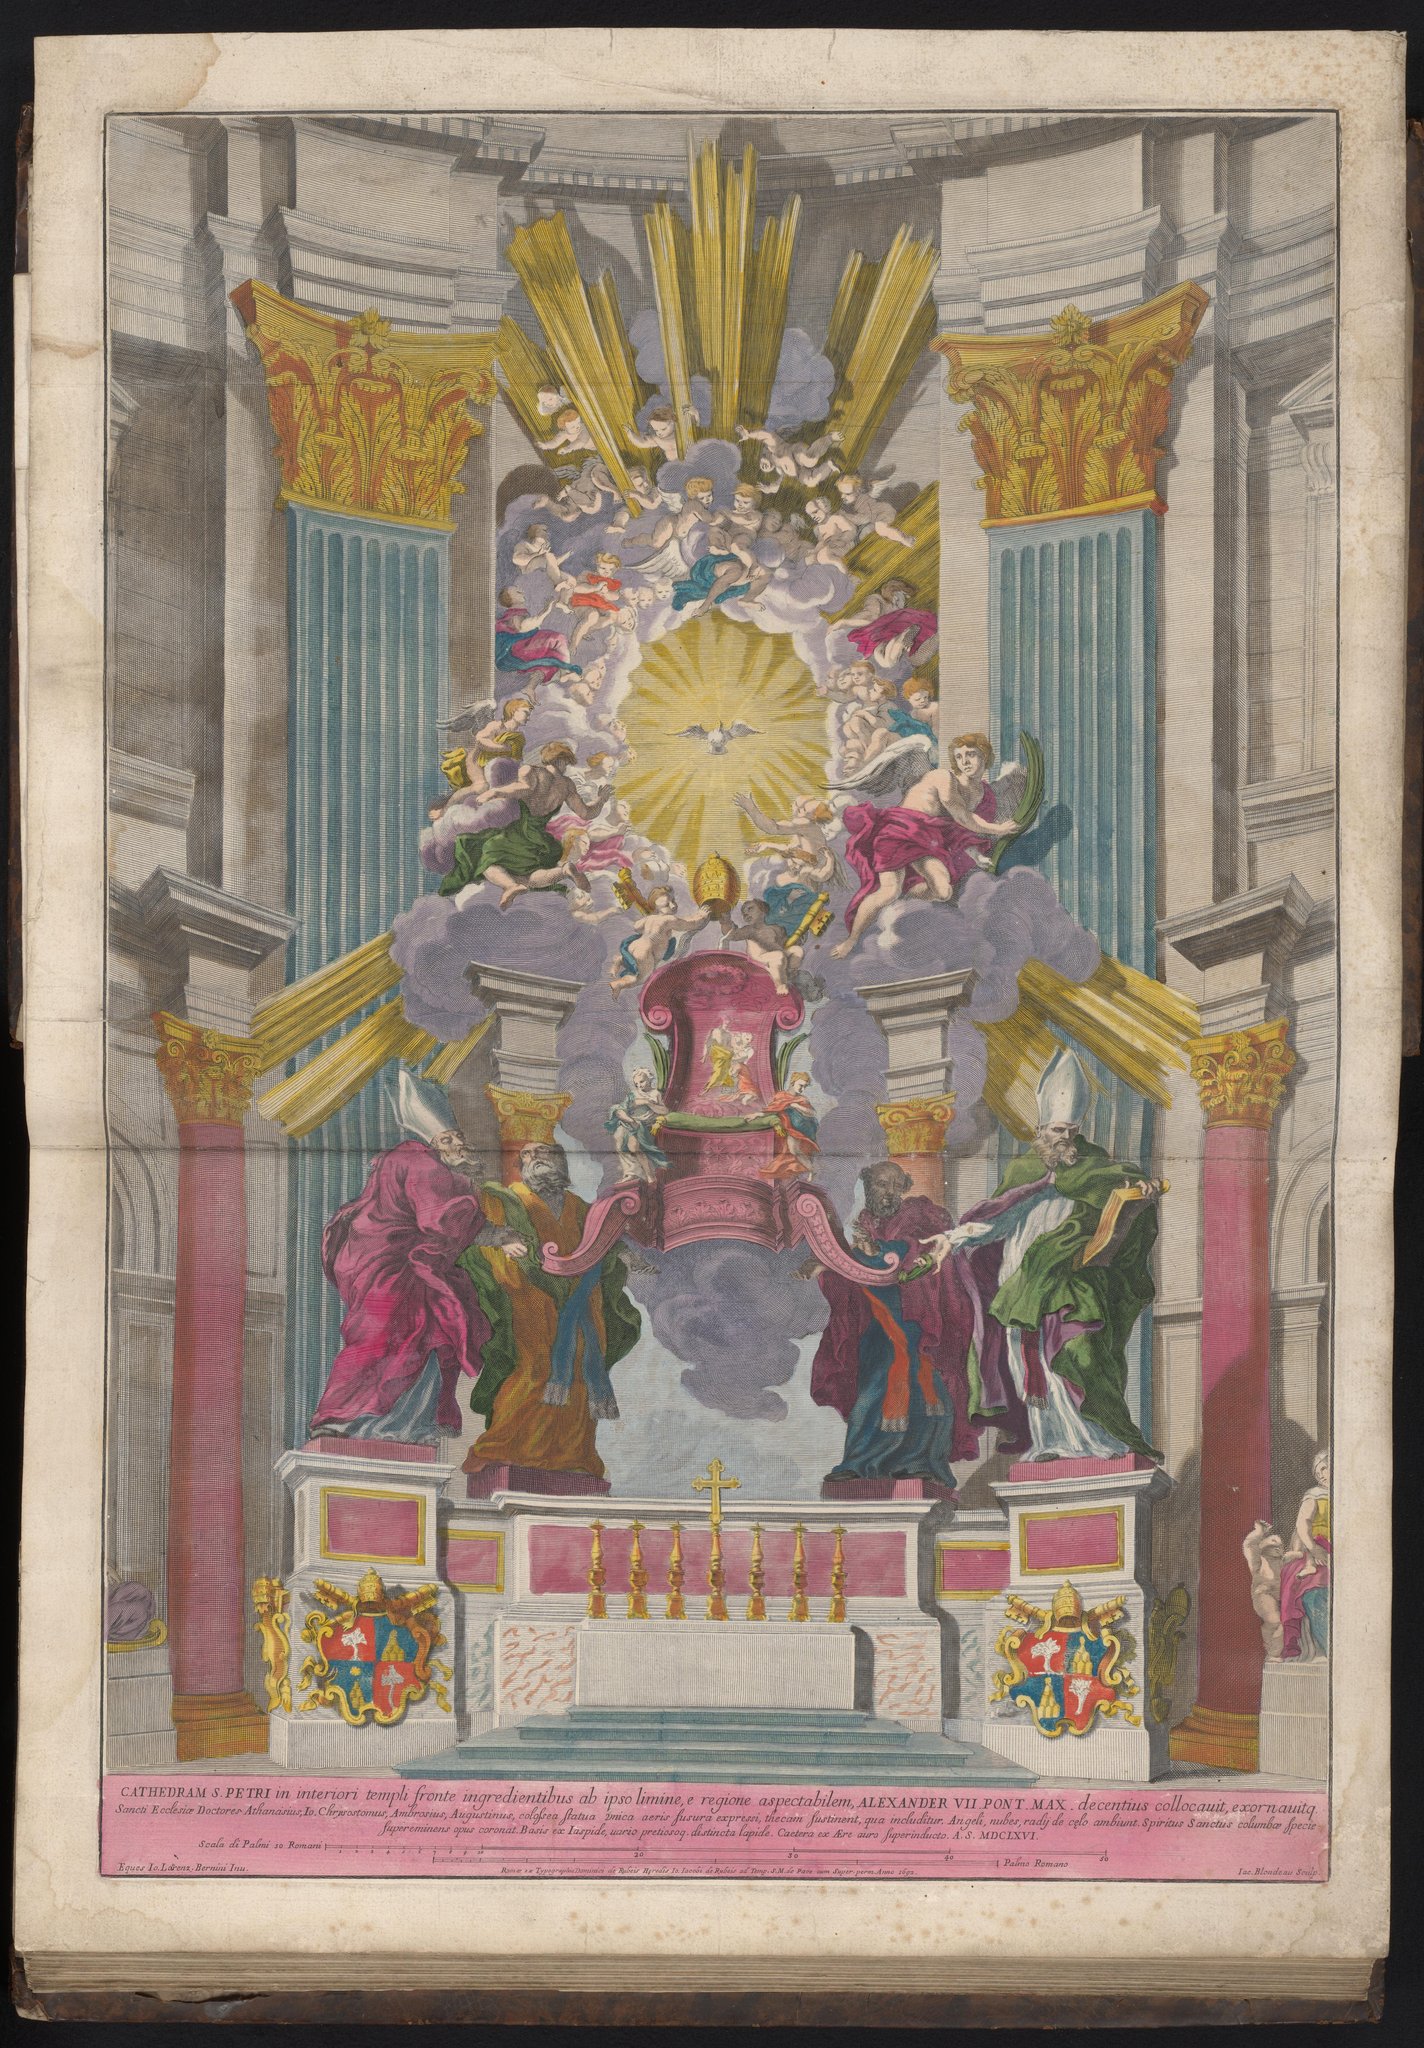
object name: album leaf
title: Cathedra Petri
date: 1692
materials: paper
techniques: colour, etching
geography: rome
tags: interior of church, piece of sculpture, reproduction of a piece of sculpture, bishop's throne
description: De Cathedra Petri, het altaar waarin het reliek van de katheder van de apostel Petrus wordt bewaard achter in de Sint-Pietersbasiliek in Vaticaanstad. Aan weerszijden van de stoel staan twee beelden van de kerkvaders. Tekst in ondermarge. Prent maakt deel uit van een album.